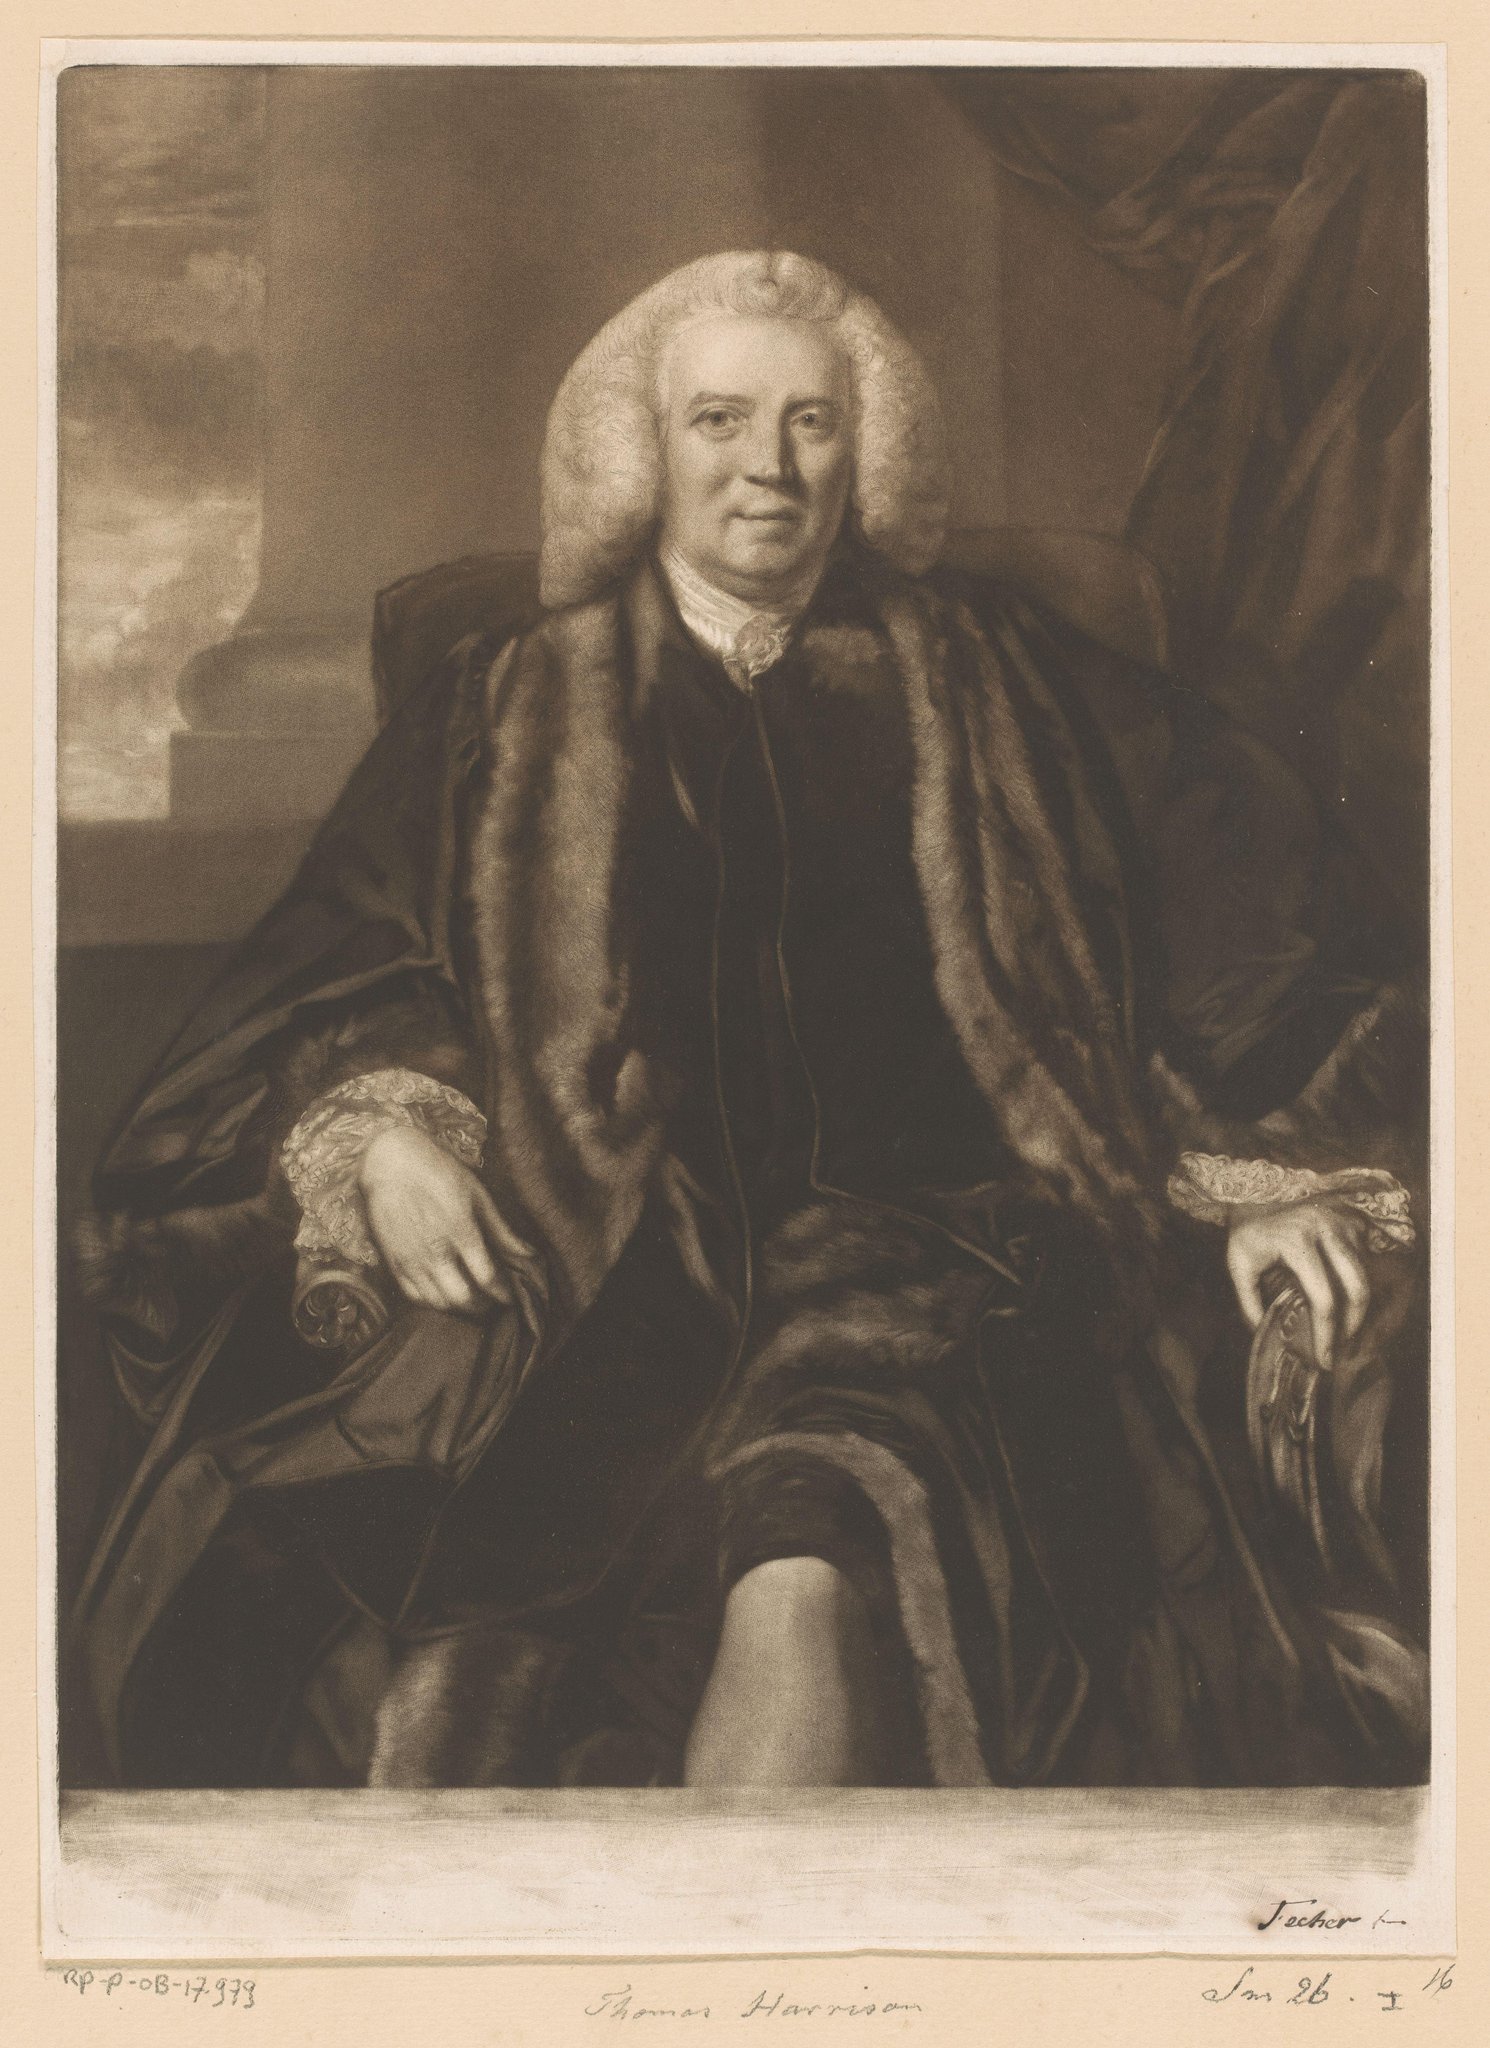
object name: print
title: Portret van Thomas Harrison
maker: edward fisher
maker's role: print maker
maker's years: 1722-1785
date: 1765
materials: paper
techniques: mezzotint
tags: historical persons, politician, e.g. party leader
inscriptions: collector's mark: Lugt 240, inscription: ‘Fecher’